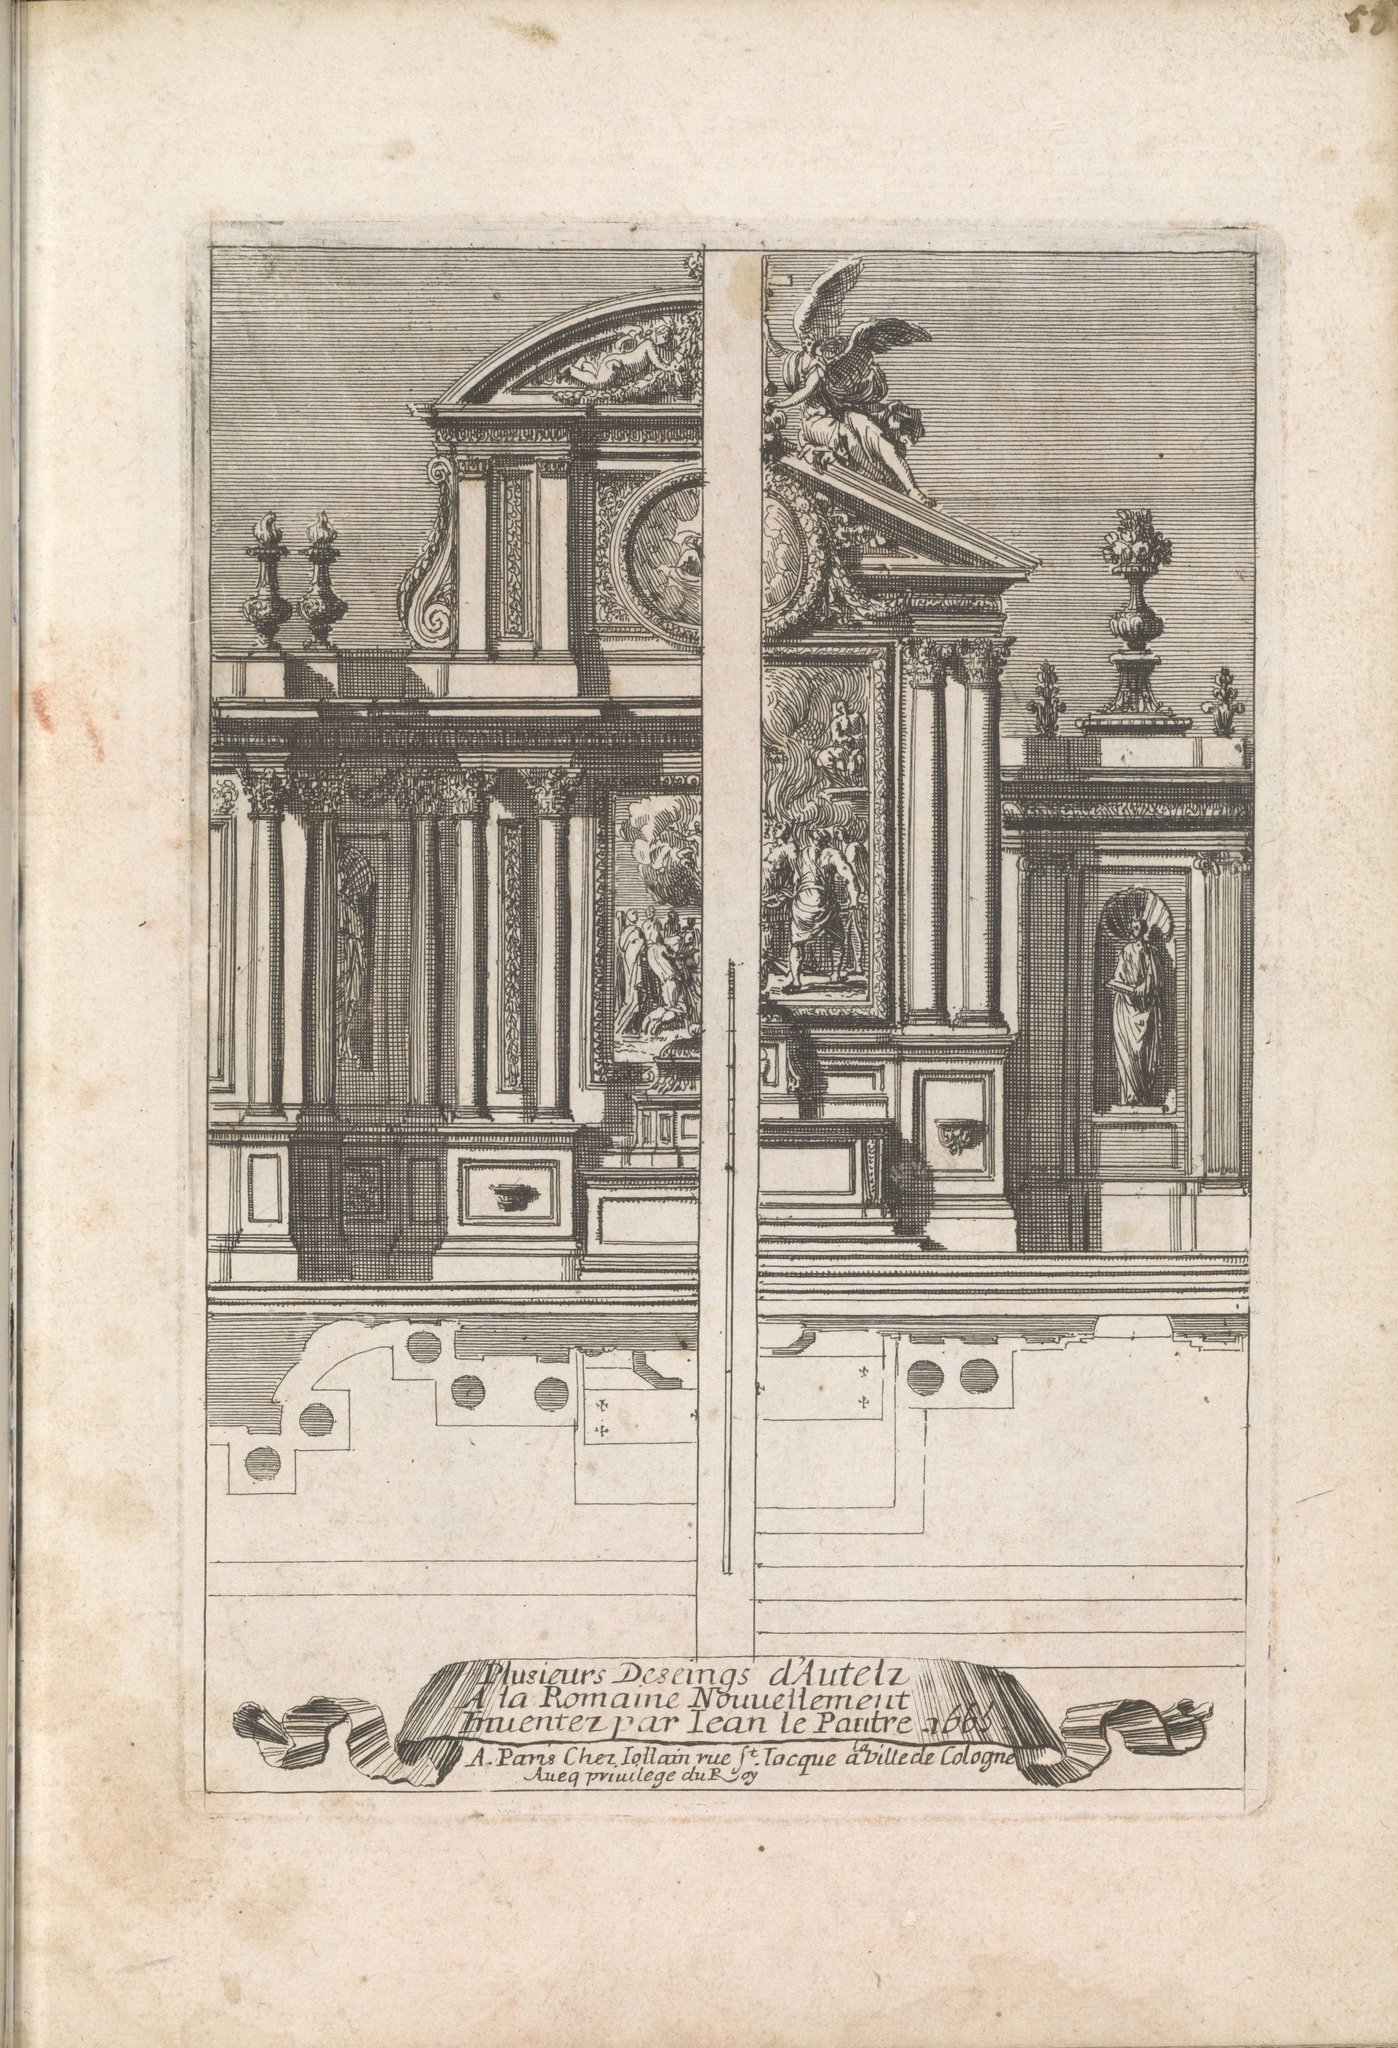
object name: print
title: Plusieurs Deseings d'Autelz A la Romaine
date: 1665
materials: paper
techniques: etching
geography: paris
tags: altar with altar-piece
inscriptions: date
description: Tirelprent voor een serie ontwerpen voor altaren op de Romeinse manier. Links een altaar met vrijstaande Korinthische zuilen. Rechts een altaar met een schilderij bekroond door een engel. Onderaan de plattegronden. Prent maakt deel uit van een album.